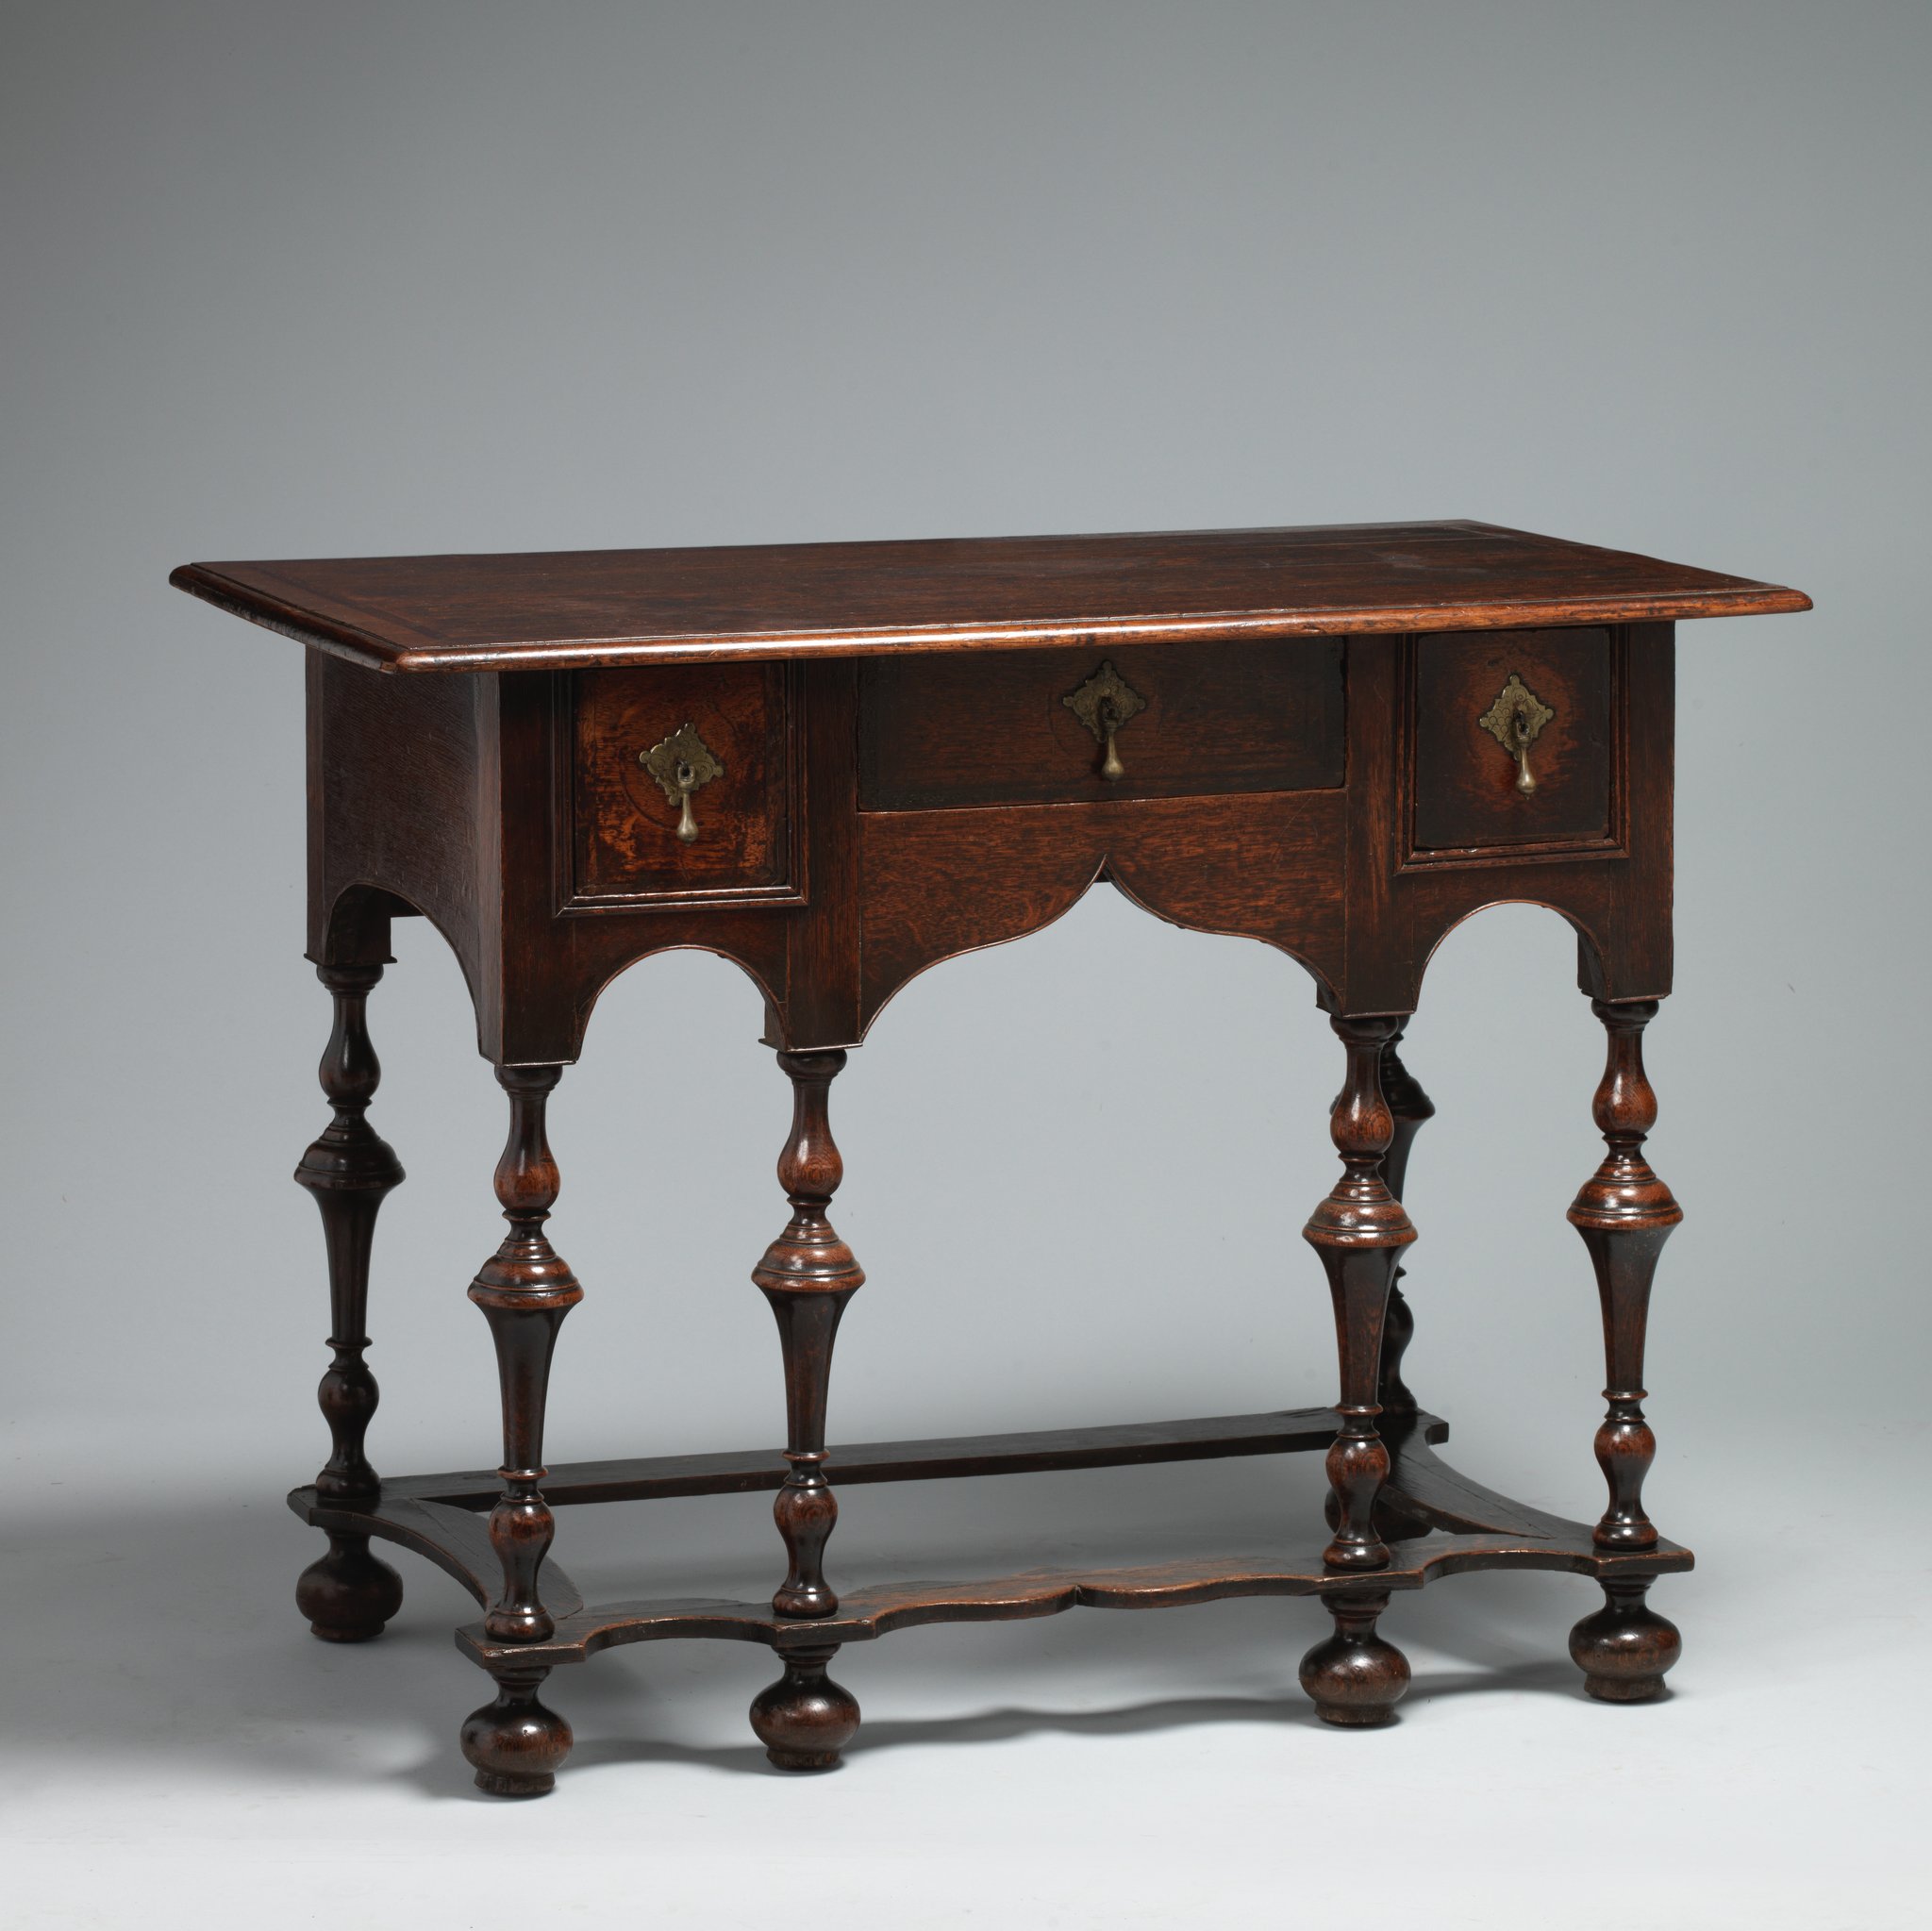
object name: dressing table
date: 1690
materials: wood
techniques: veneering